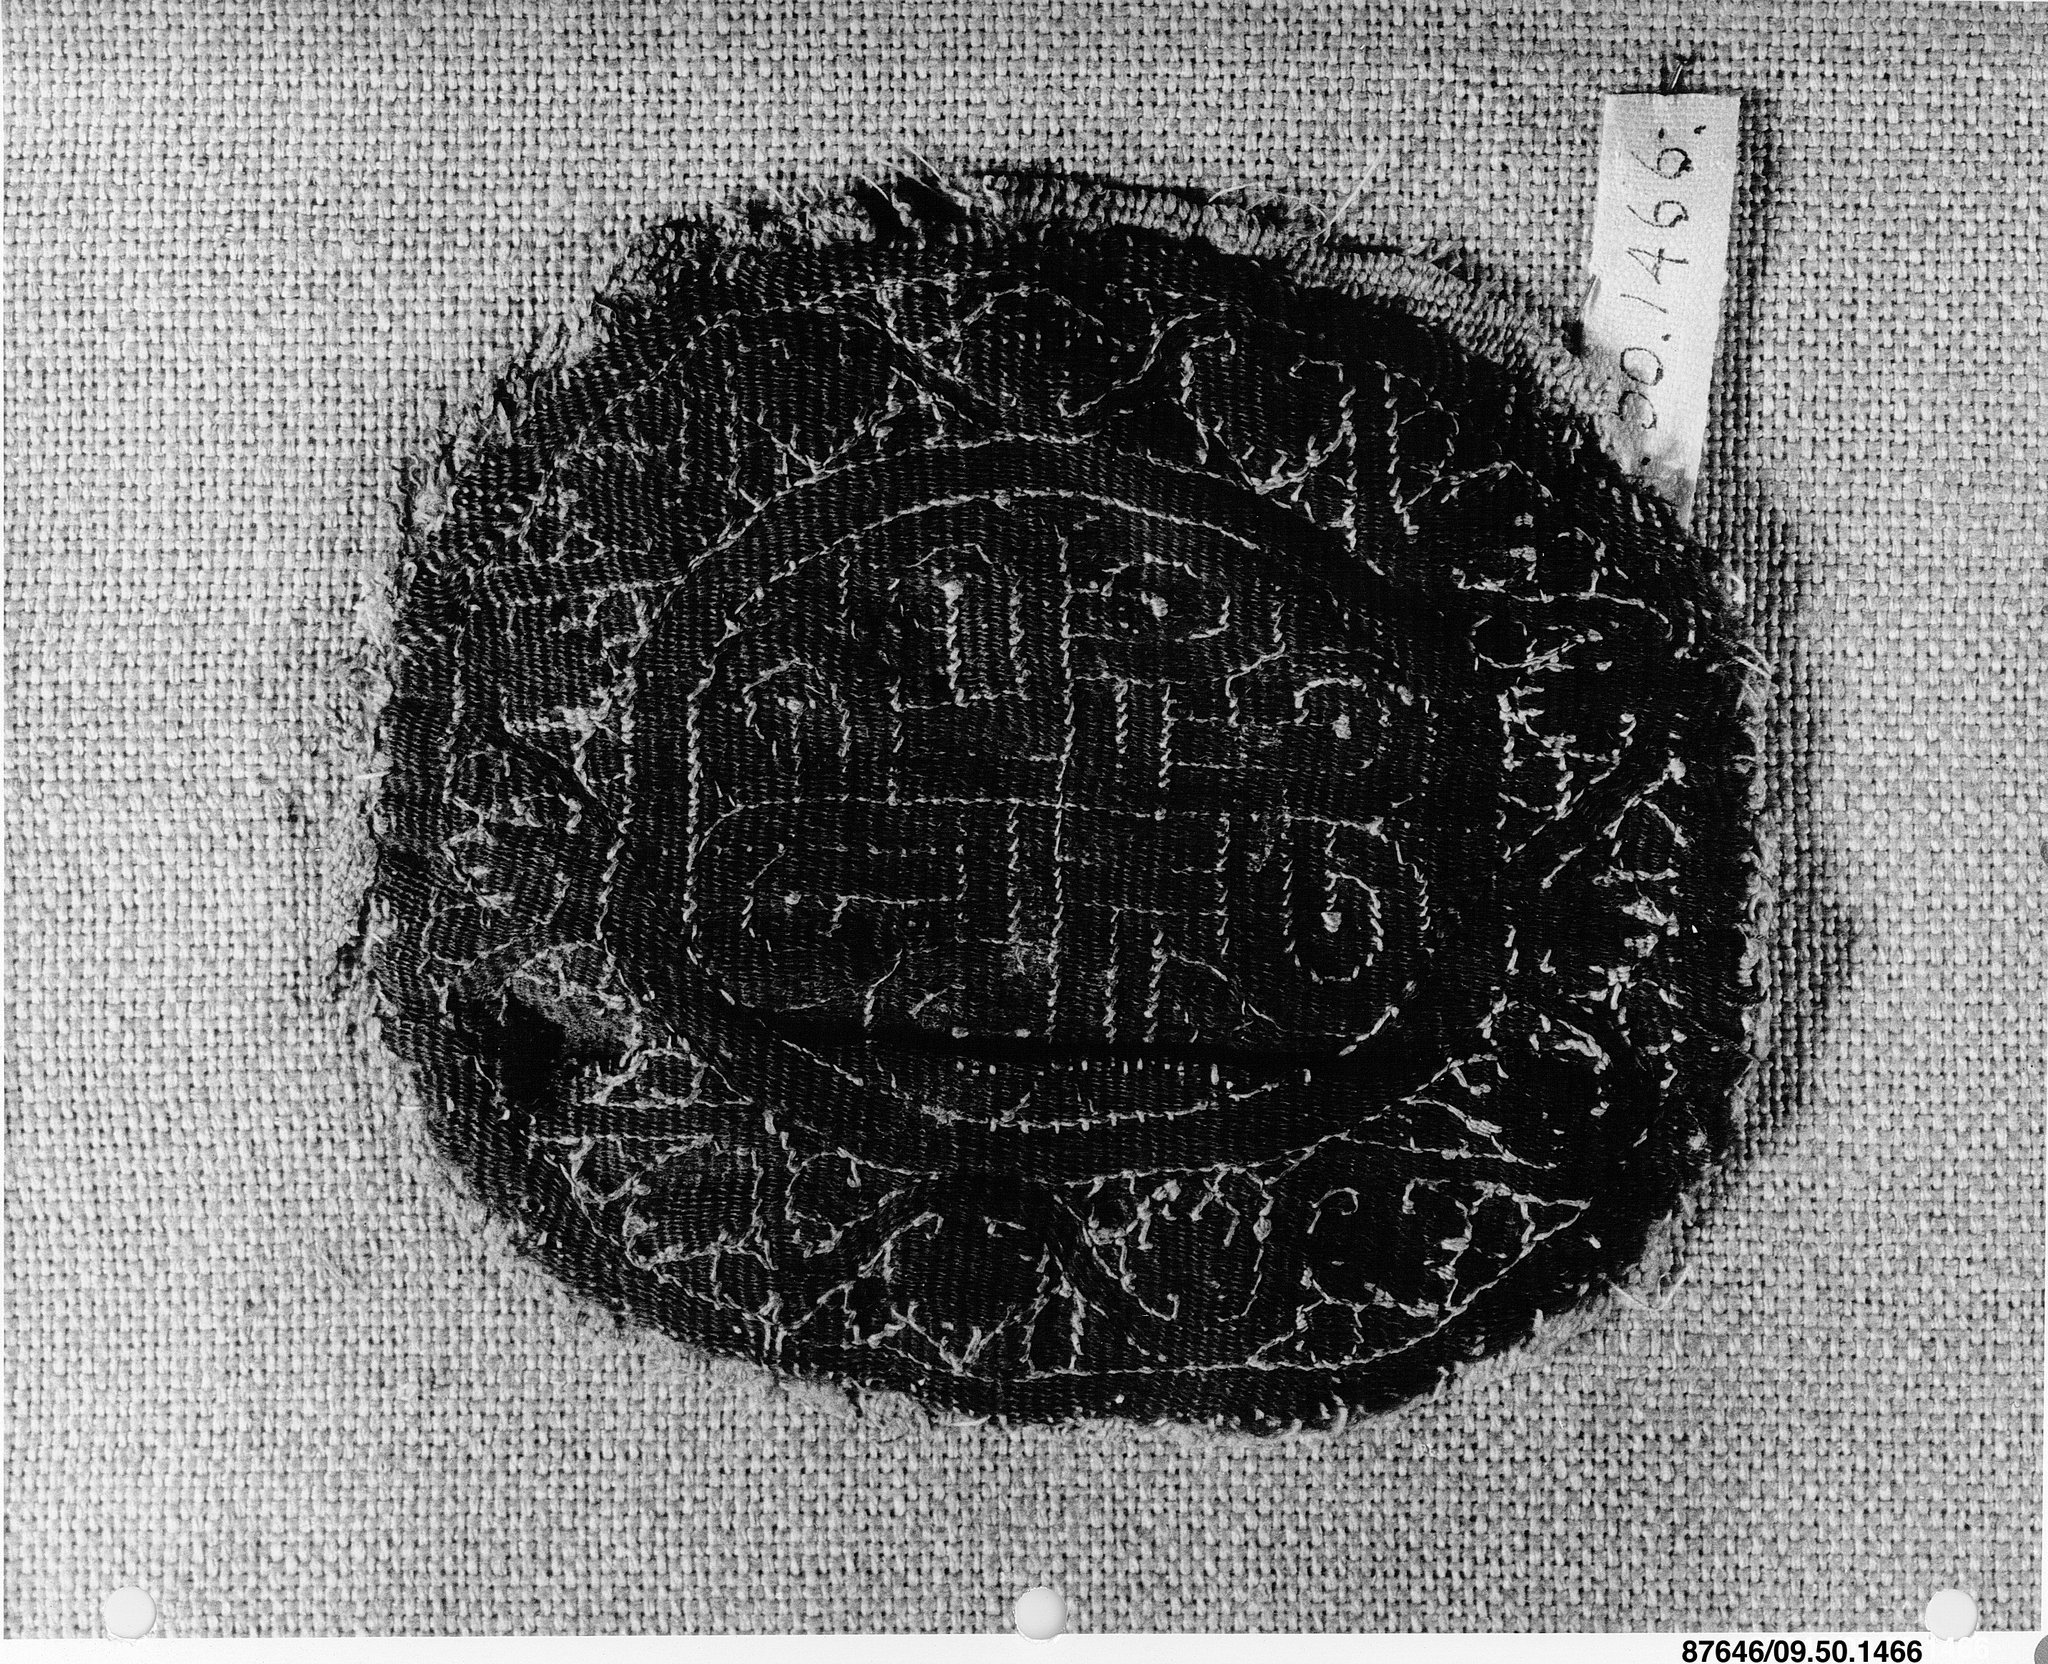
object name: roundel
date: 301-500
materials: linen, wool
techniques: weave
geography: egypt